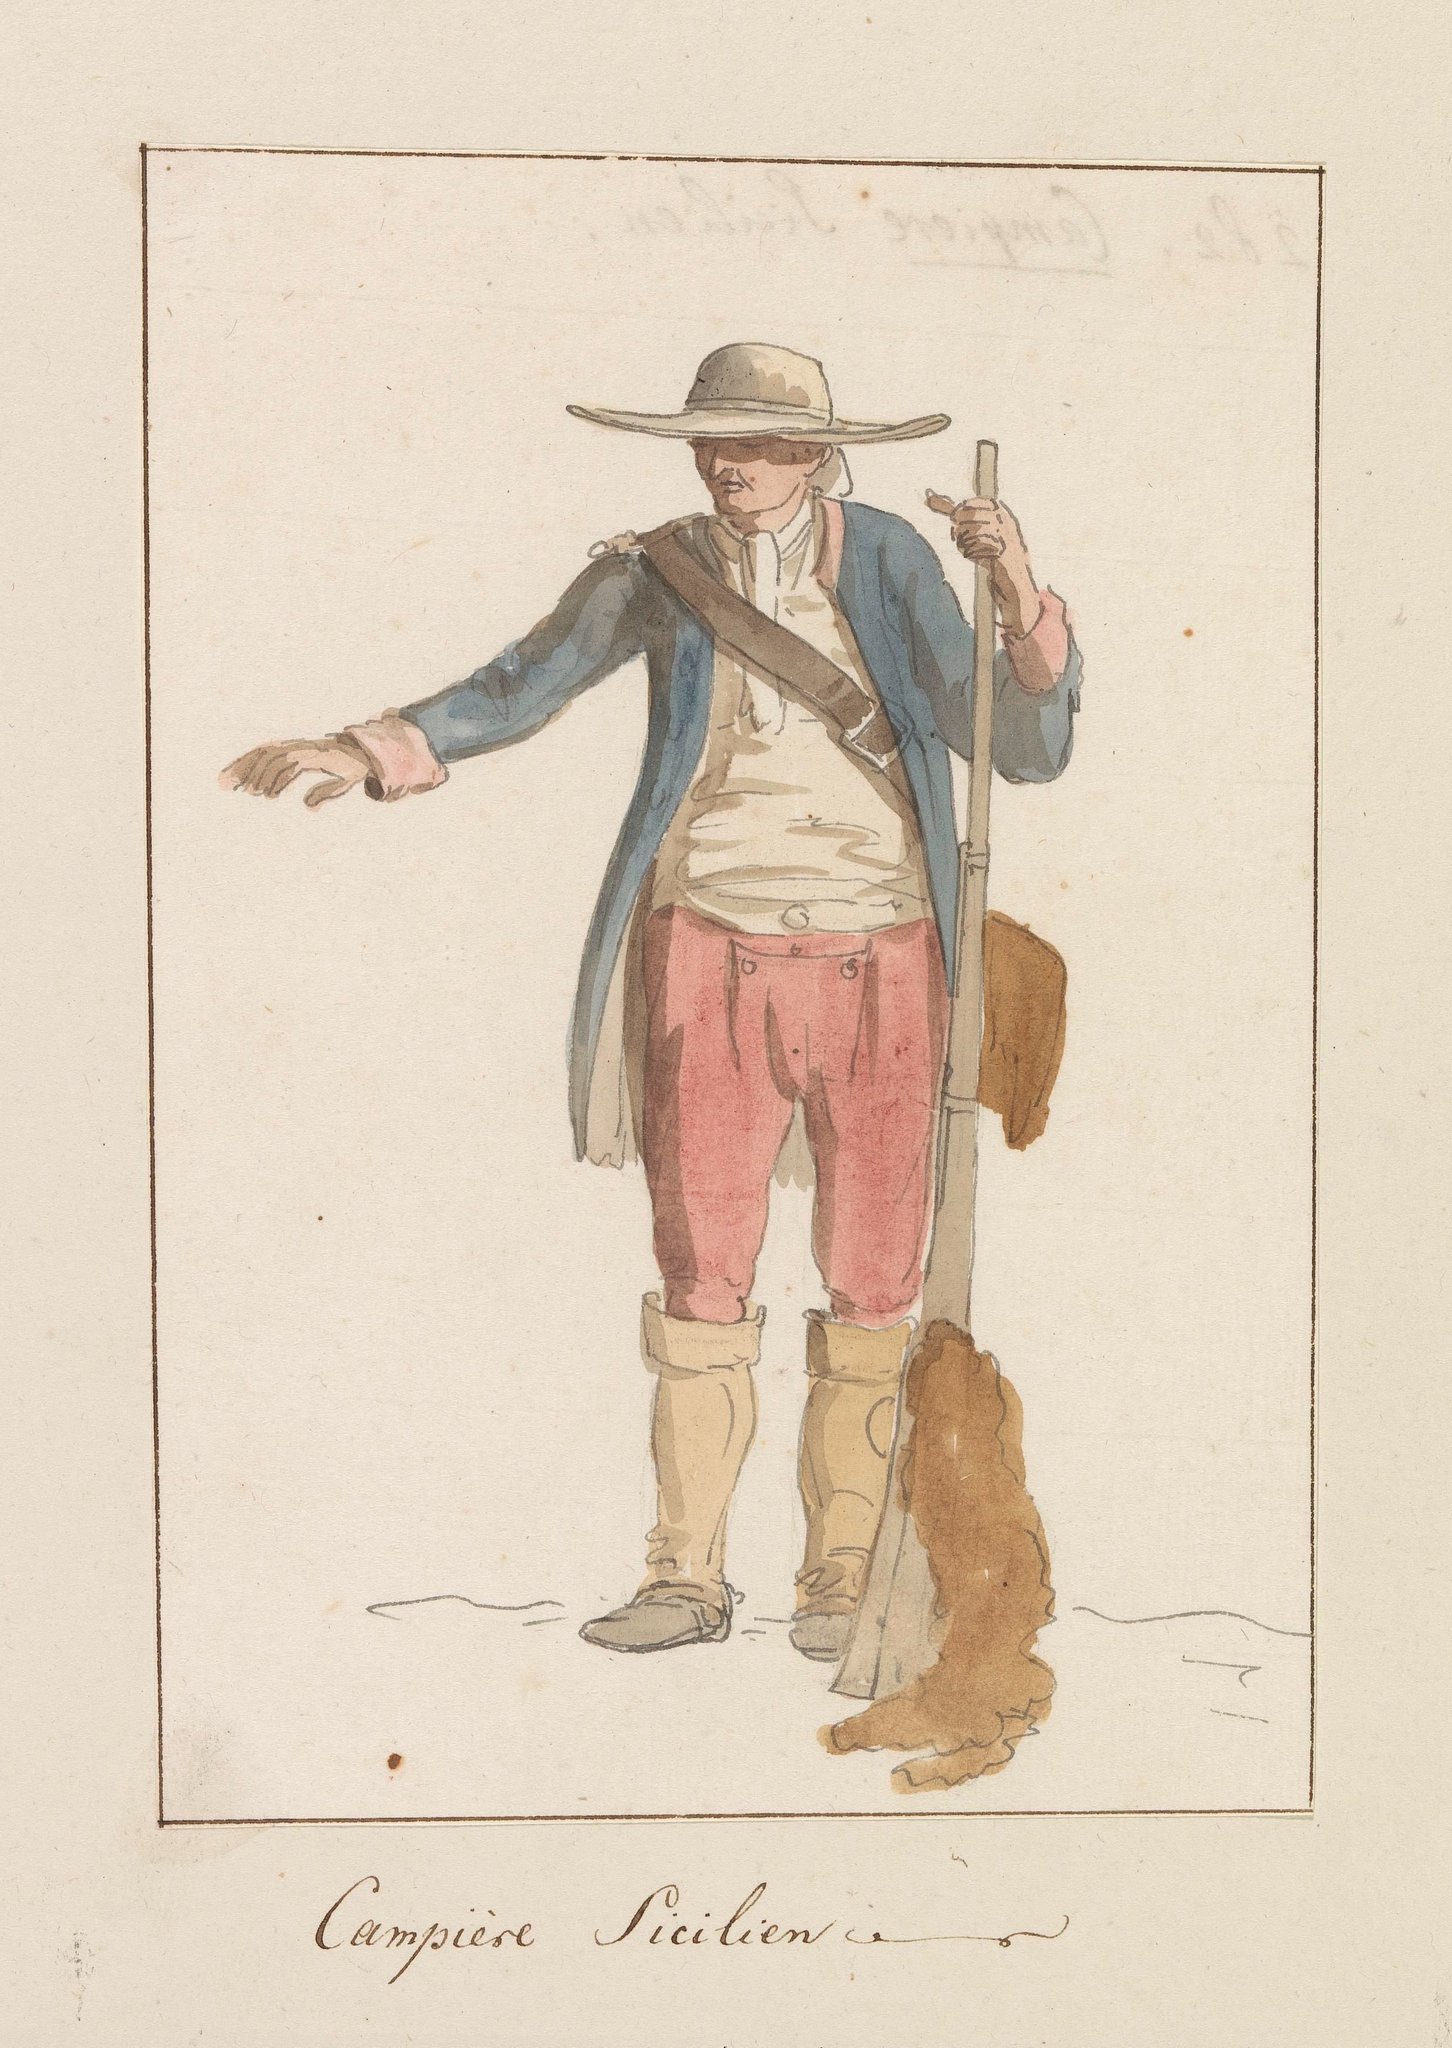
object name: drawing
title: Voyage en Italie, en Sicile et à Malte - 1778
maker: louis ducros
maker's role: draughtsman, print maker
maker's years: 1748-1810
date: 1778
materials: chalk, paper, watercolor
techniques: brush, pen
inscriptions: inscription: ‘No 282 Campière Sicilien’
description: Tekening uit het album 'Voyage en Italie, en Sicile et à Malte', 1778.